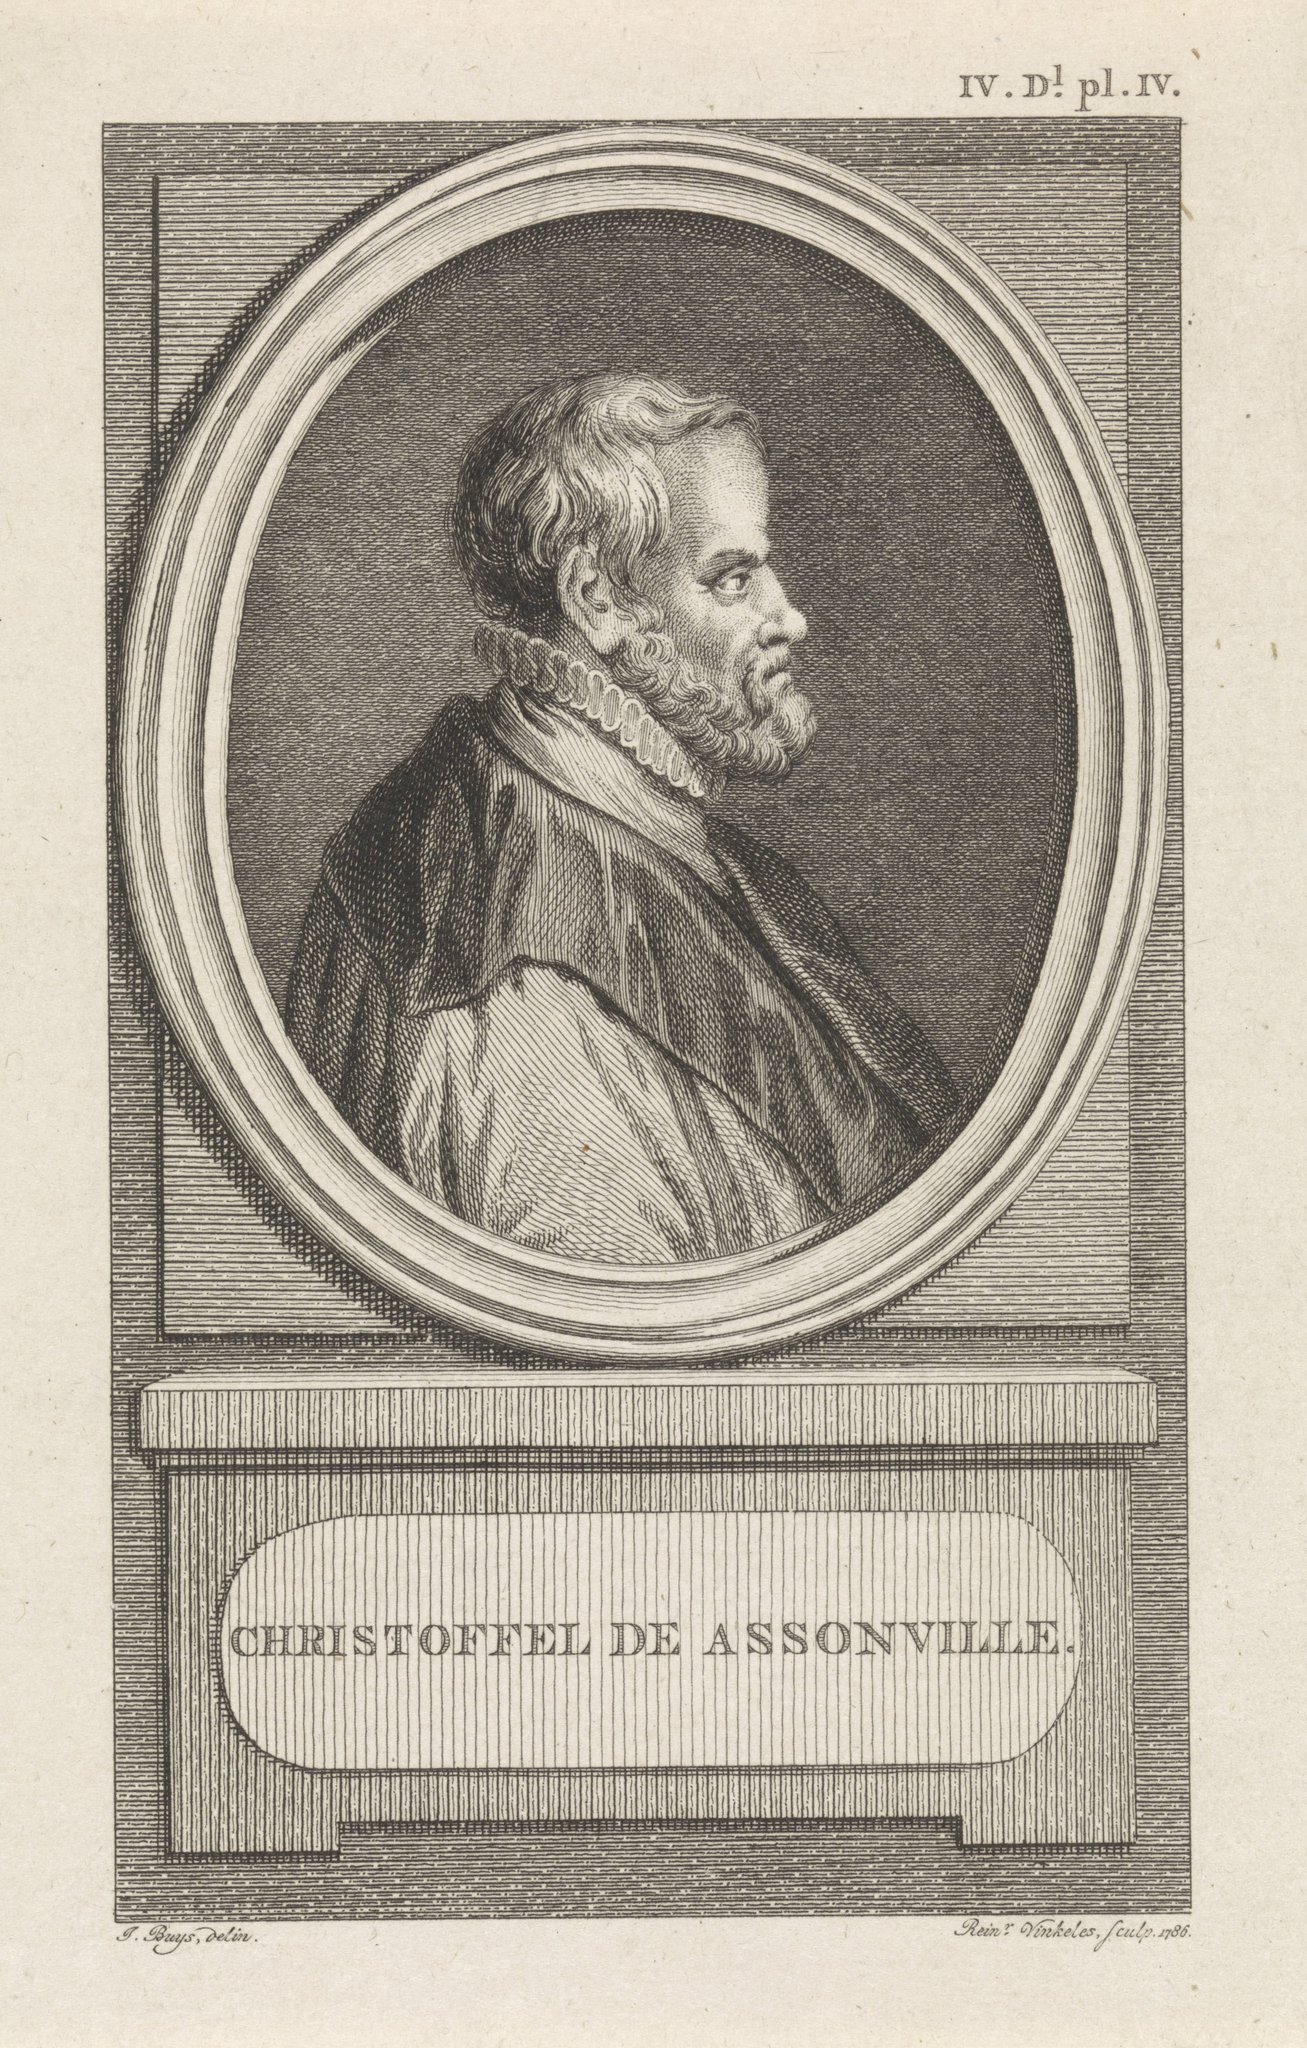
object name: print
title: Portret van Christoffel de Assonville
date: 1786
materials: paper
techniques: engraving, etching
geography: amsterdam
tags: brussels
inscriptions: collector's mark: Lugt 2228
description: Prent gebruikt als boekillustratie in: Kok, Jacobus. Vaderlandsch woordenboek : met kaarten, plaaten en pourtraitten. Amsterdam: Johannes Allart, 1785-1796. Deel IV.